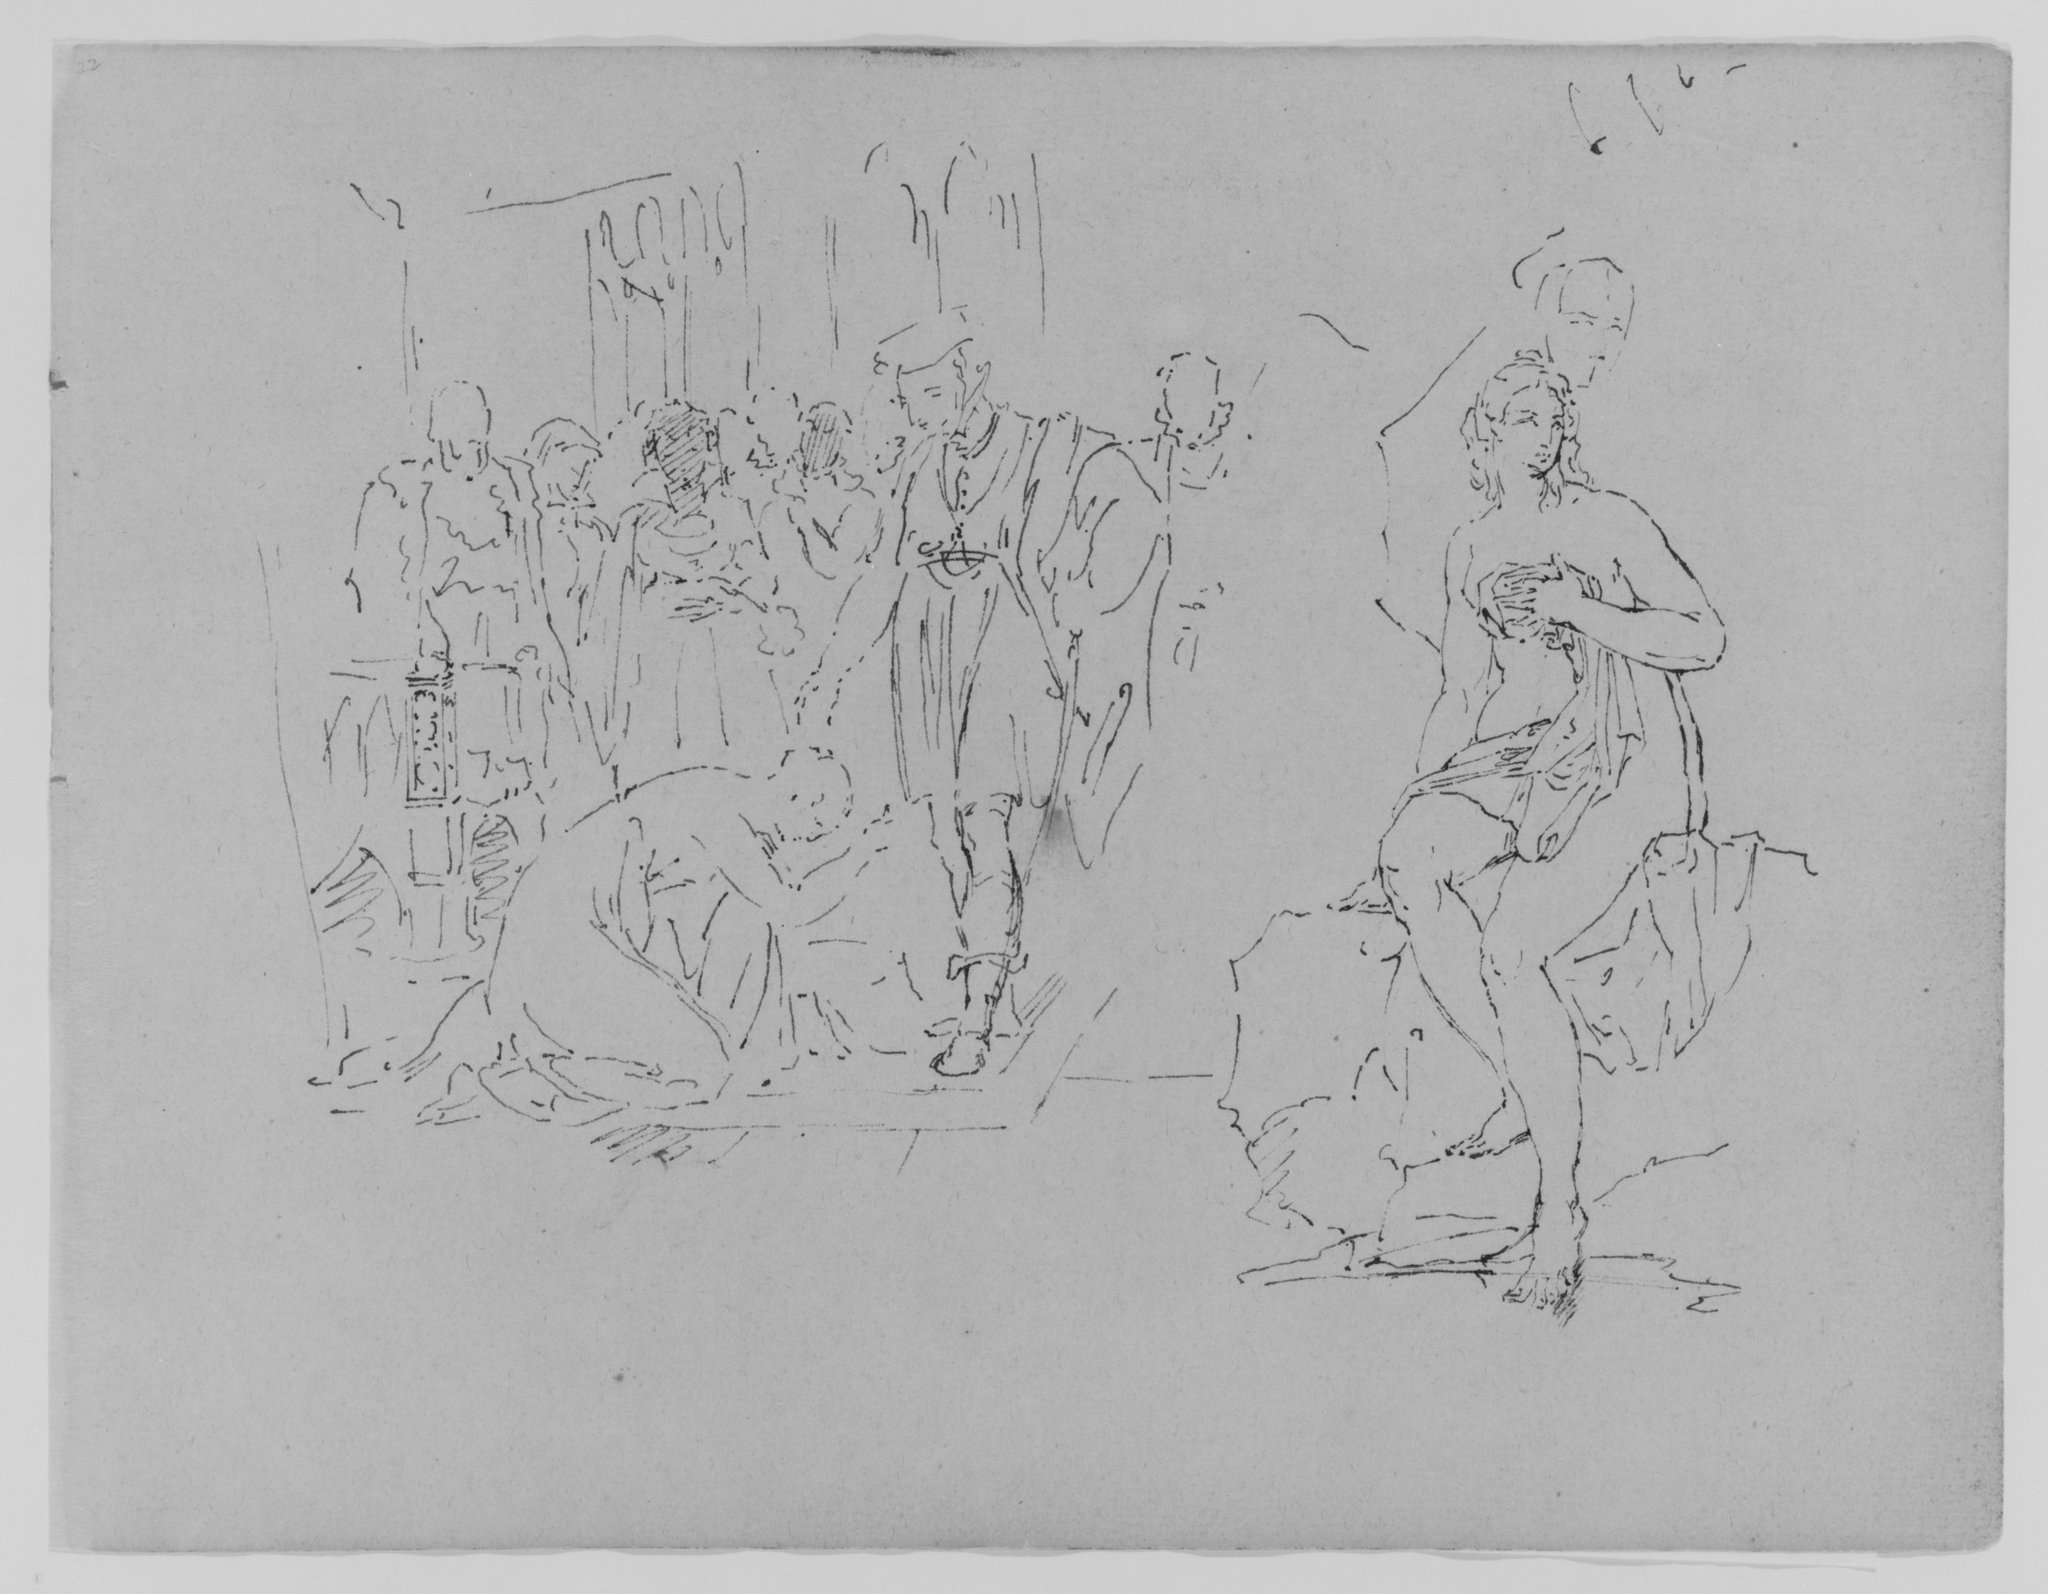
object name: drawing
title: Woman Prostrate Before a Nobleman; Nude Bather Seated on a Rock (Diana?) (from Sketchbook)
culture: american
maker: thomas sully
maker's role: artist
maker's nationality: american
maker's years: 1783-1872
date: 1810-1820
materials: ink, paper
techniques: wash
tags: men,women,female nudes,crowd